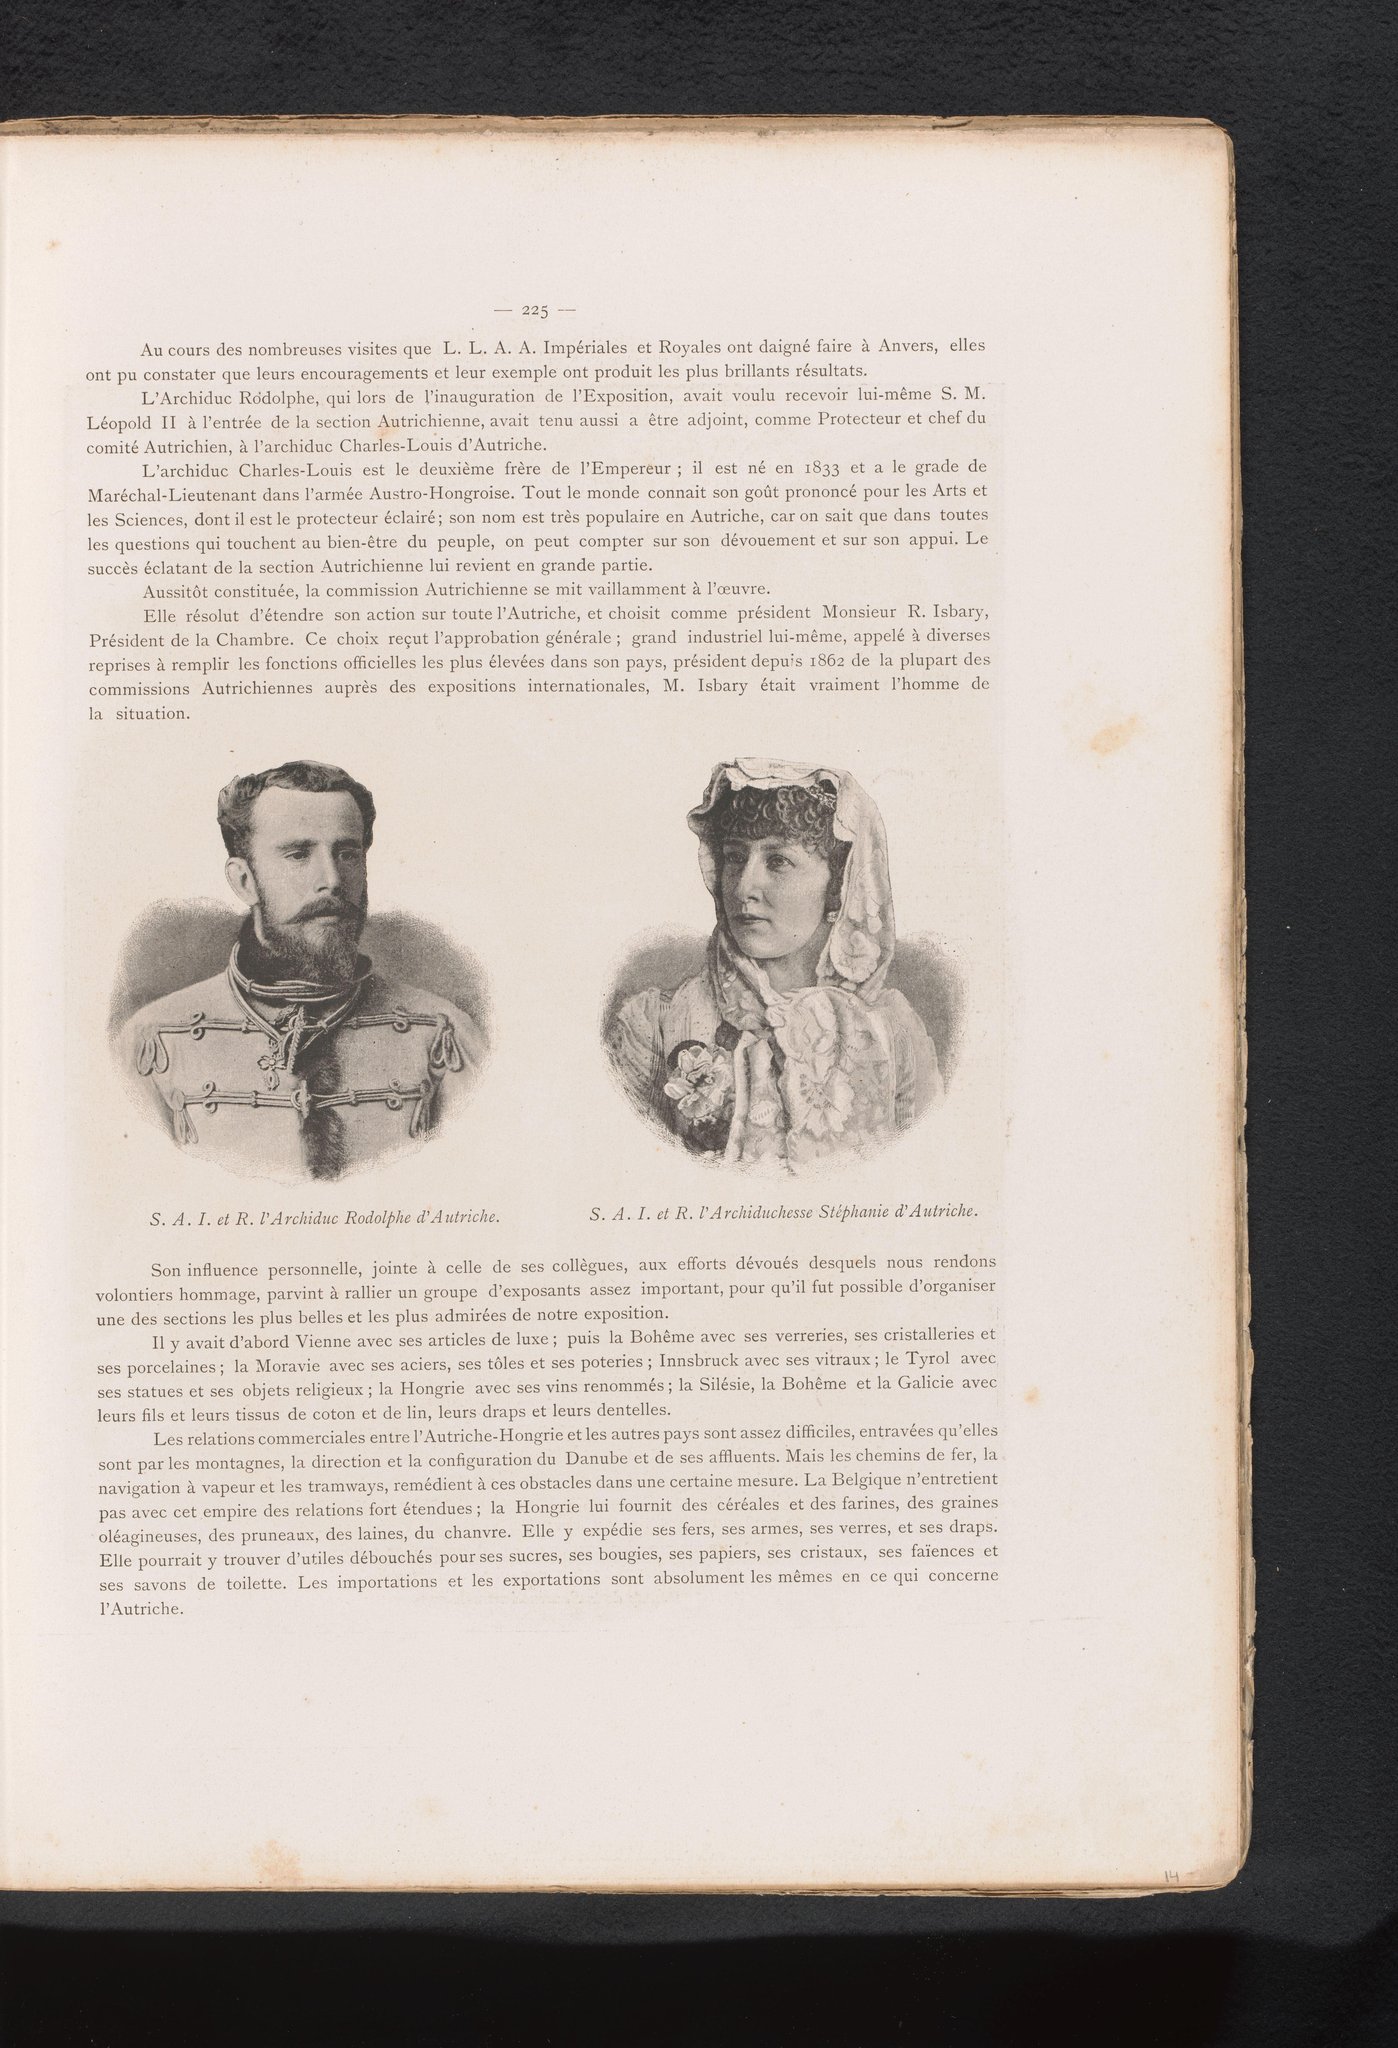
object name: photomechanical print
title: Portret van aartshertog Rudolf van Oostenrijk en een portret van aartshertogin Stefanie van België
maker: Anonymous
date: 1880-1885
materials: paper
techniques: autotype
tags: brussels, historical persons - bb - woman, aristocracy; 'aristocratia' (ripa), historical persons